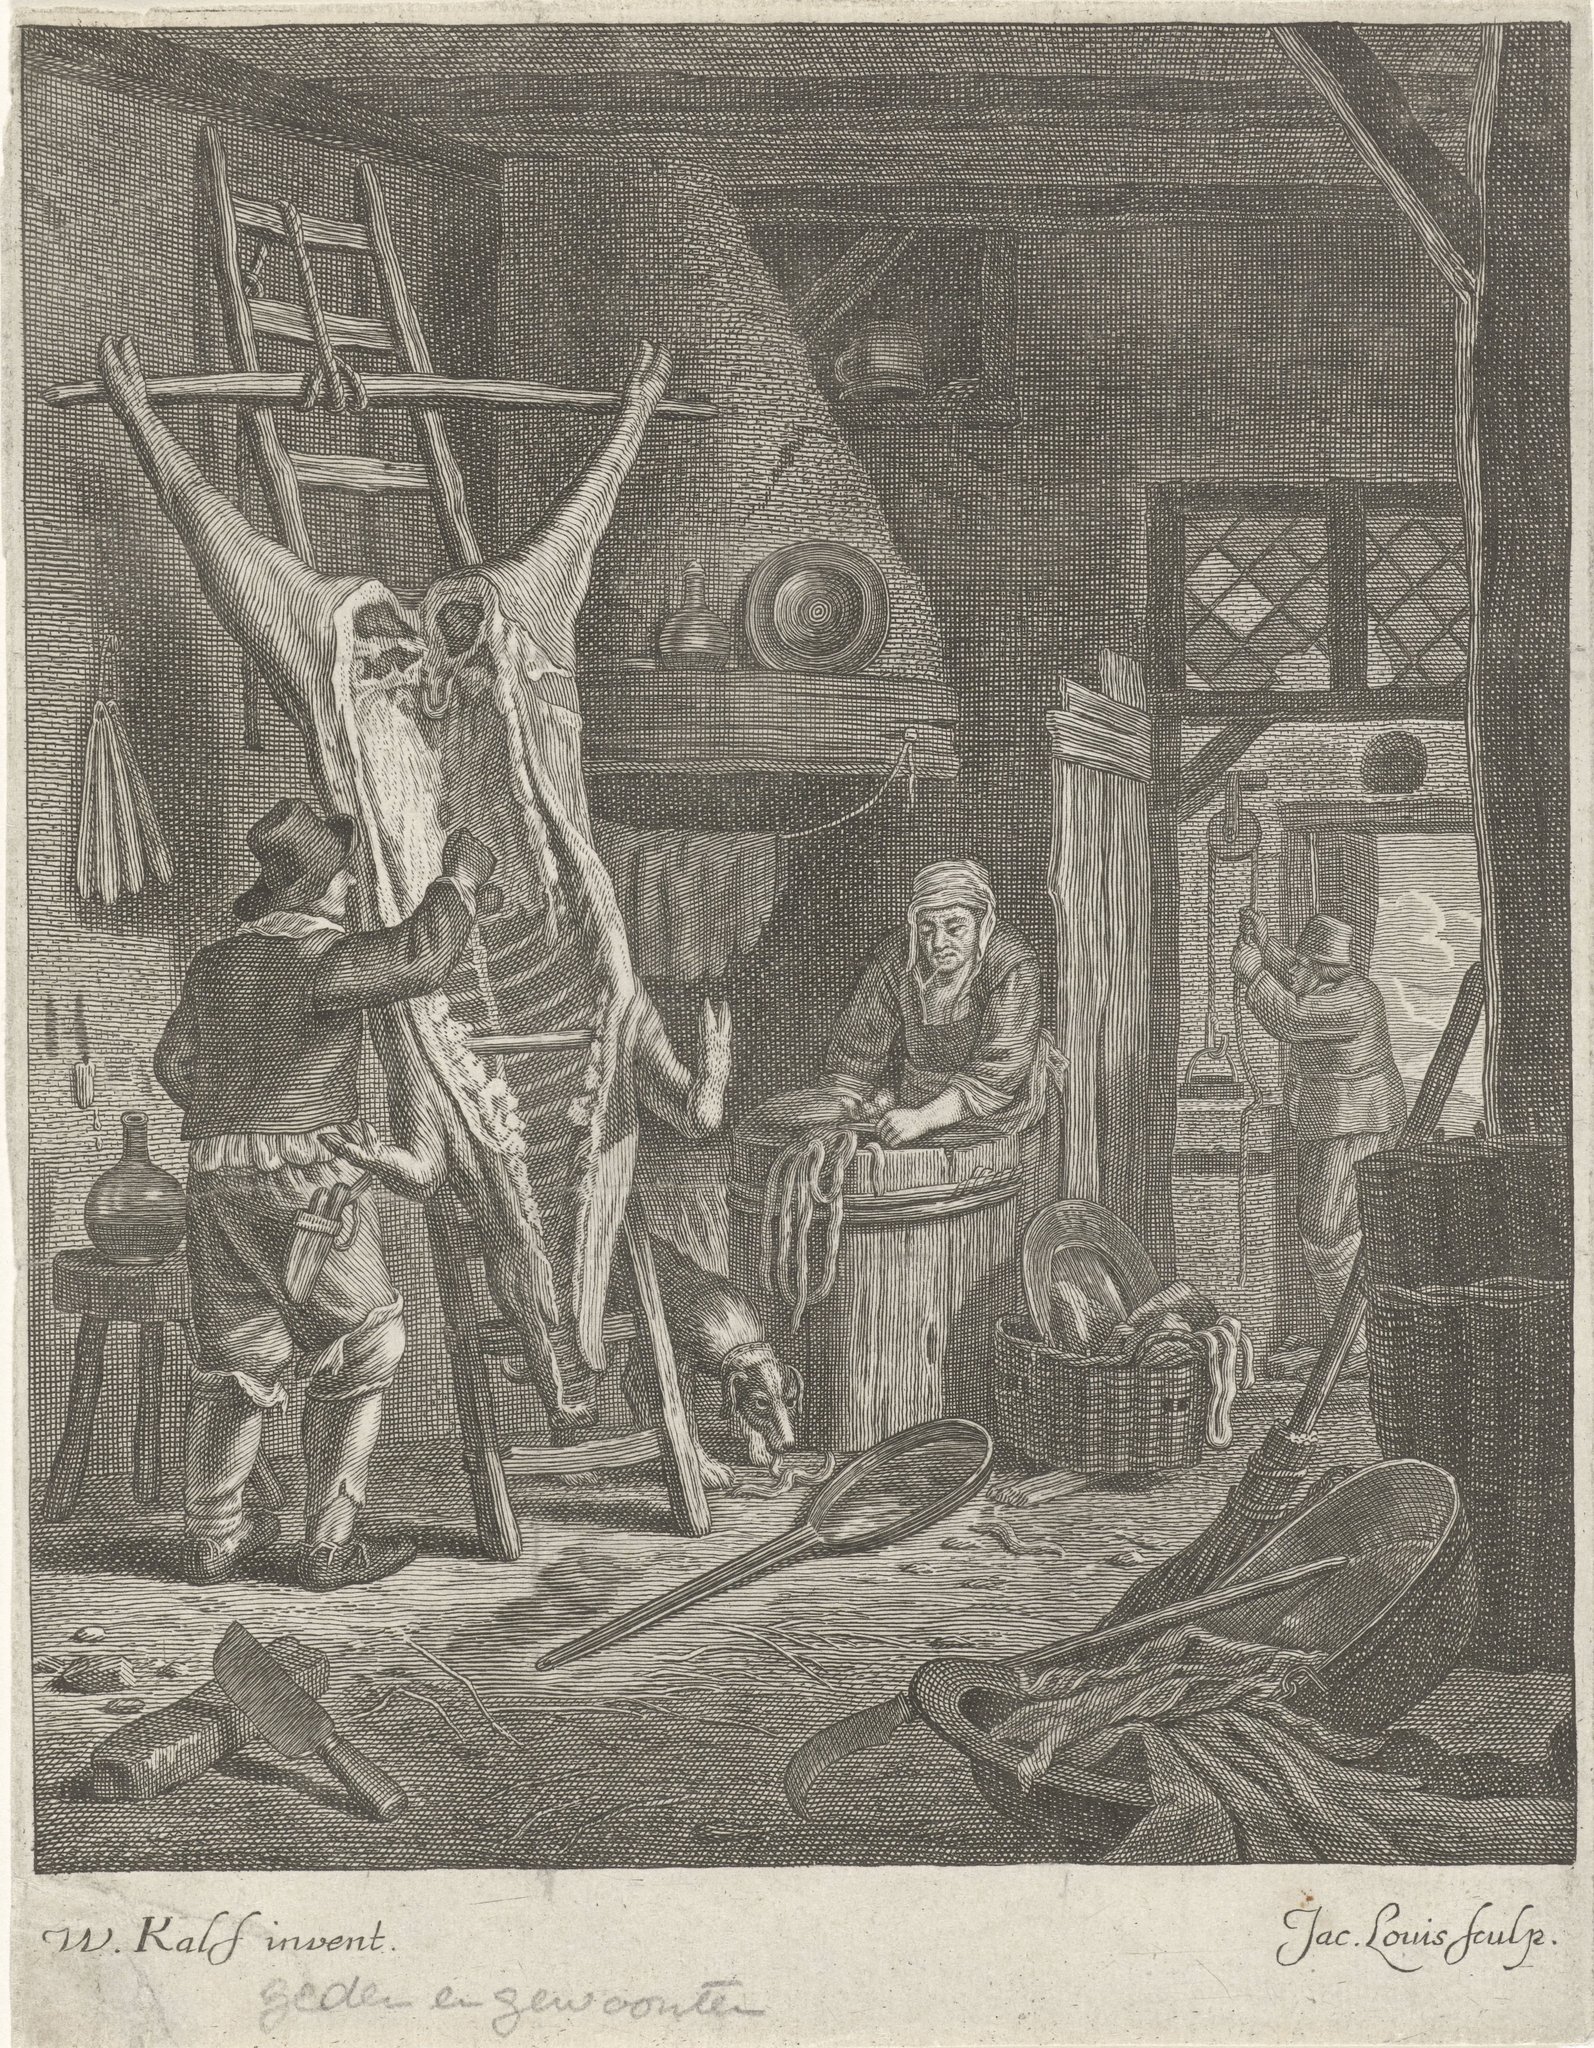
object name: print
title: Boereninterieur met geslacht varken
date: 1630-1673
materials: paper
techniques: etching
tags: slaughtered ox or pig, sausage, farm (building) - aa - civic architecture: inside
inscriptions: collector's mark: Lugt 2228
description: Een boereninterieur met een geslacht varken tegen een ladder. De boer maakt het varken schoon, de boerin staat achter een houten ton worst te maken. Op de achtergrond haalt een figuur met een emmer water uit een put.